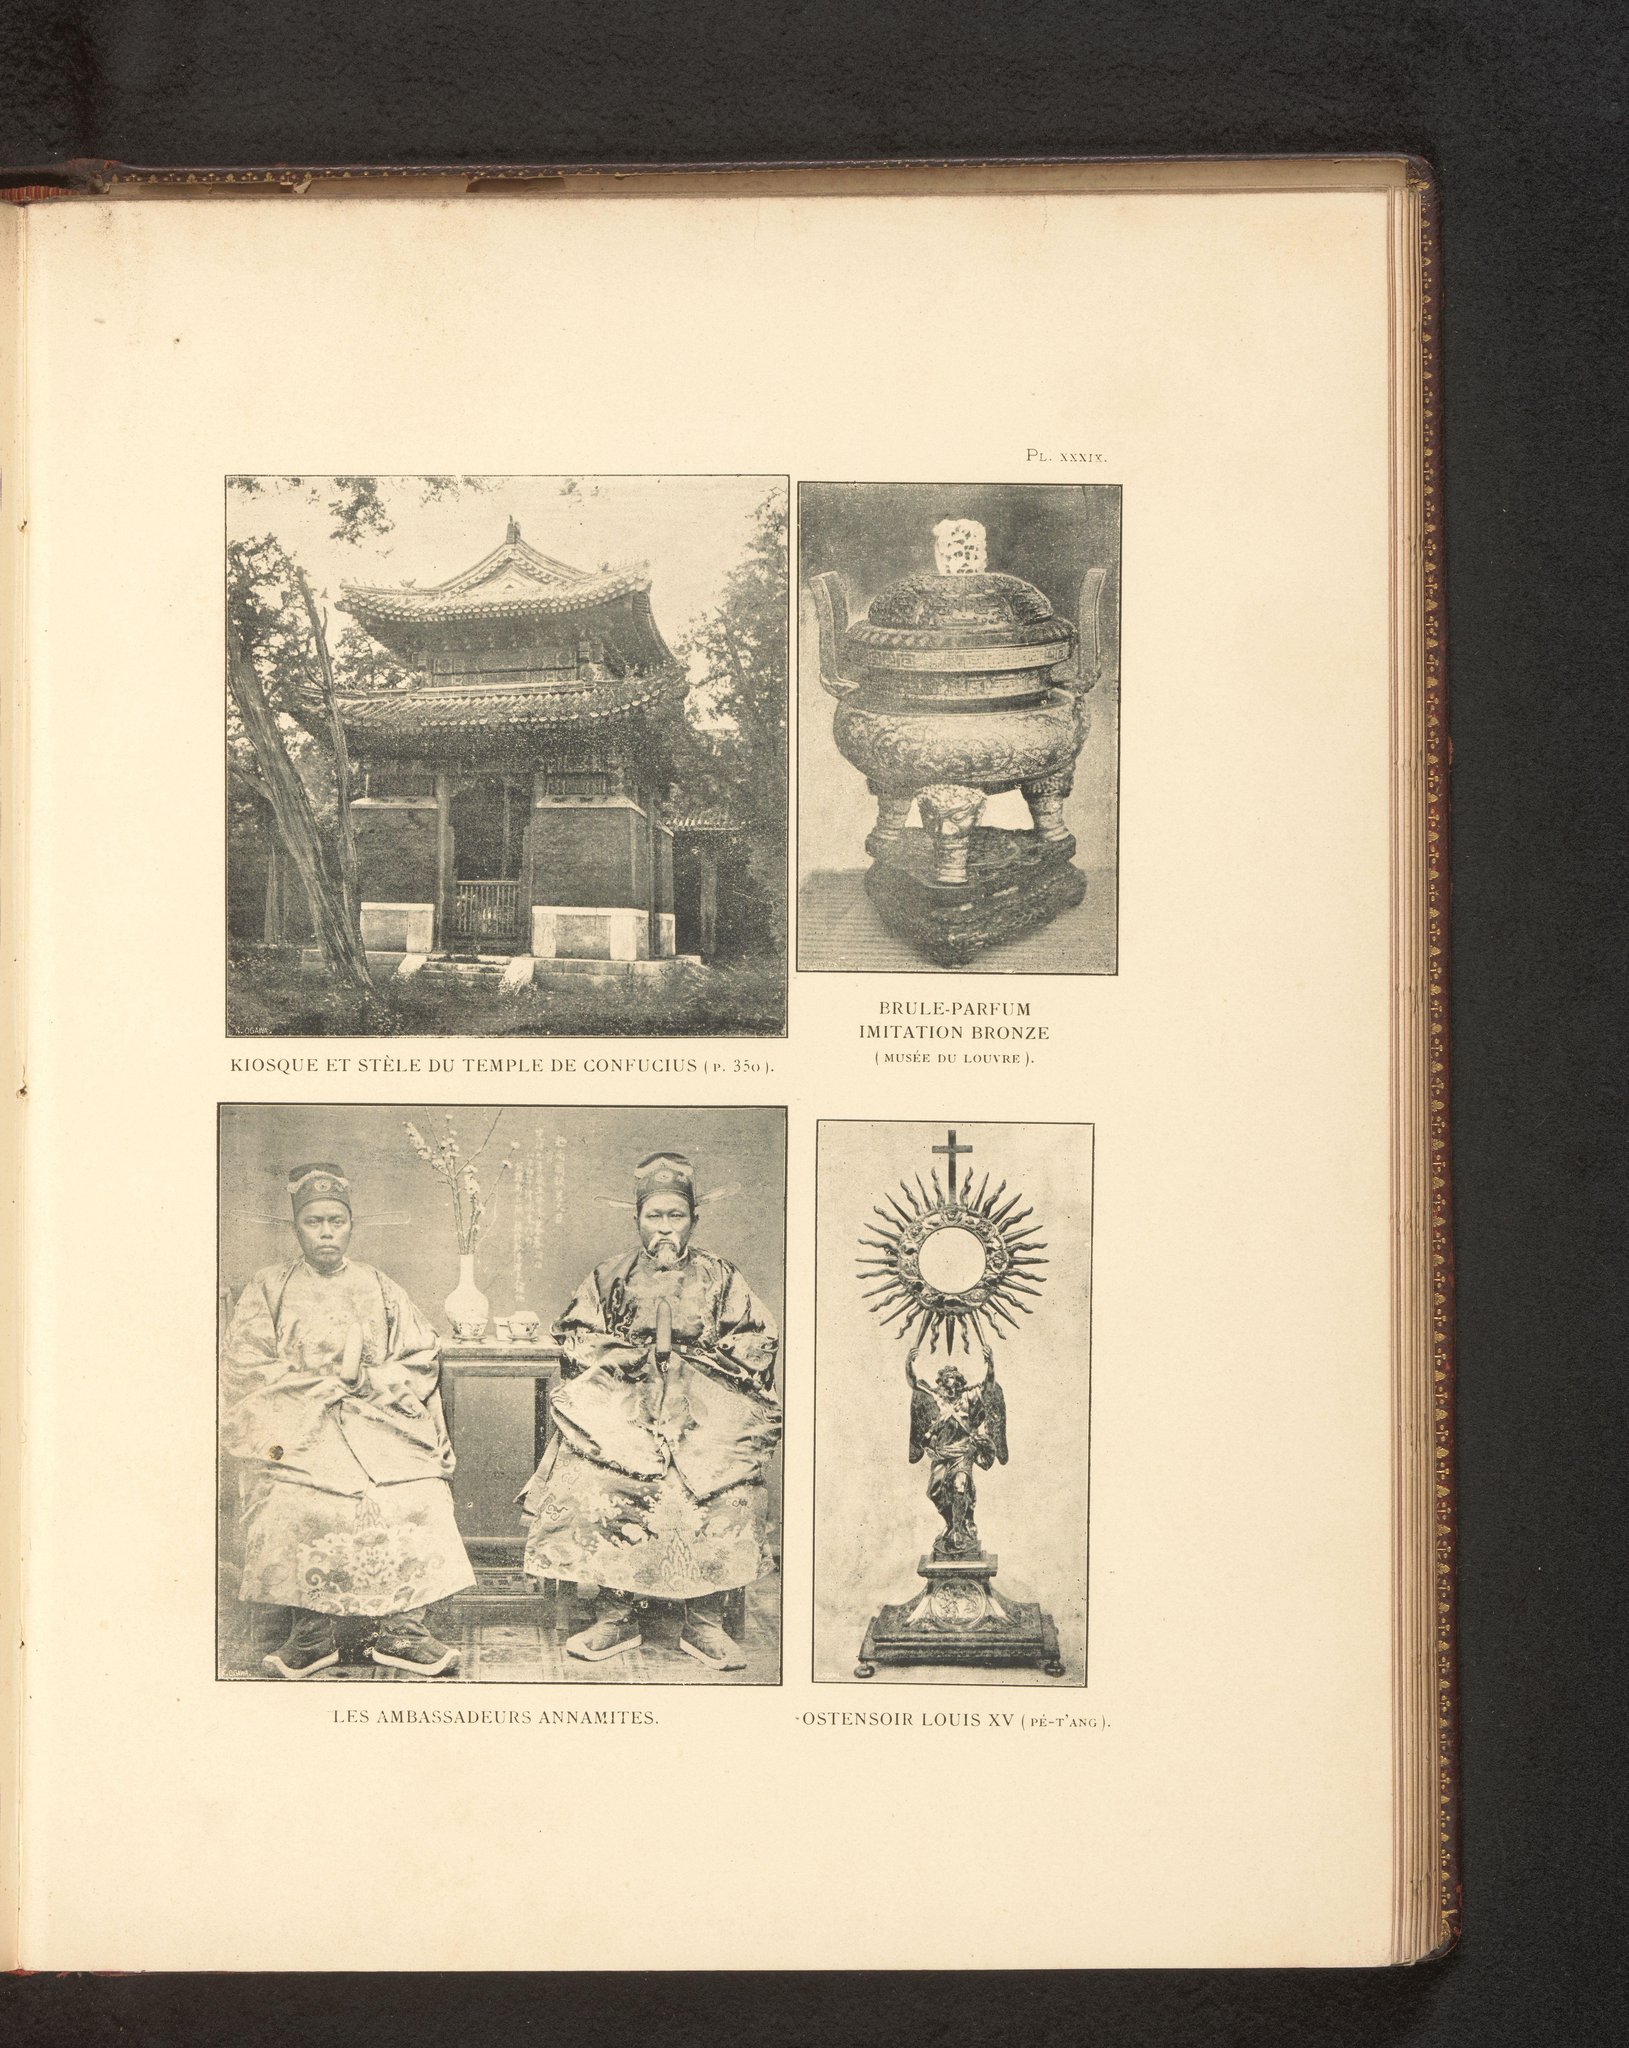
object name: photomechanical print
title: Gebouw bij de Tempel van Confucius, Wierook brander, Portret van de ambassadeurs uit Vietnam en Monstrans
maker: Anonymous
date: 1892-1897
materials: paper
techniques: autotype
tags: temple, shrine ~ traditional chinese religions, ostensorium, monstrance, historical persons, incense-burner ~ scents, perfumes, china